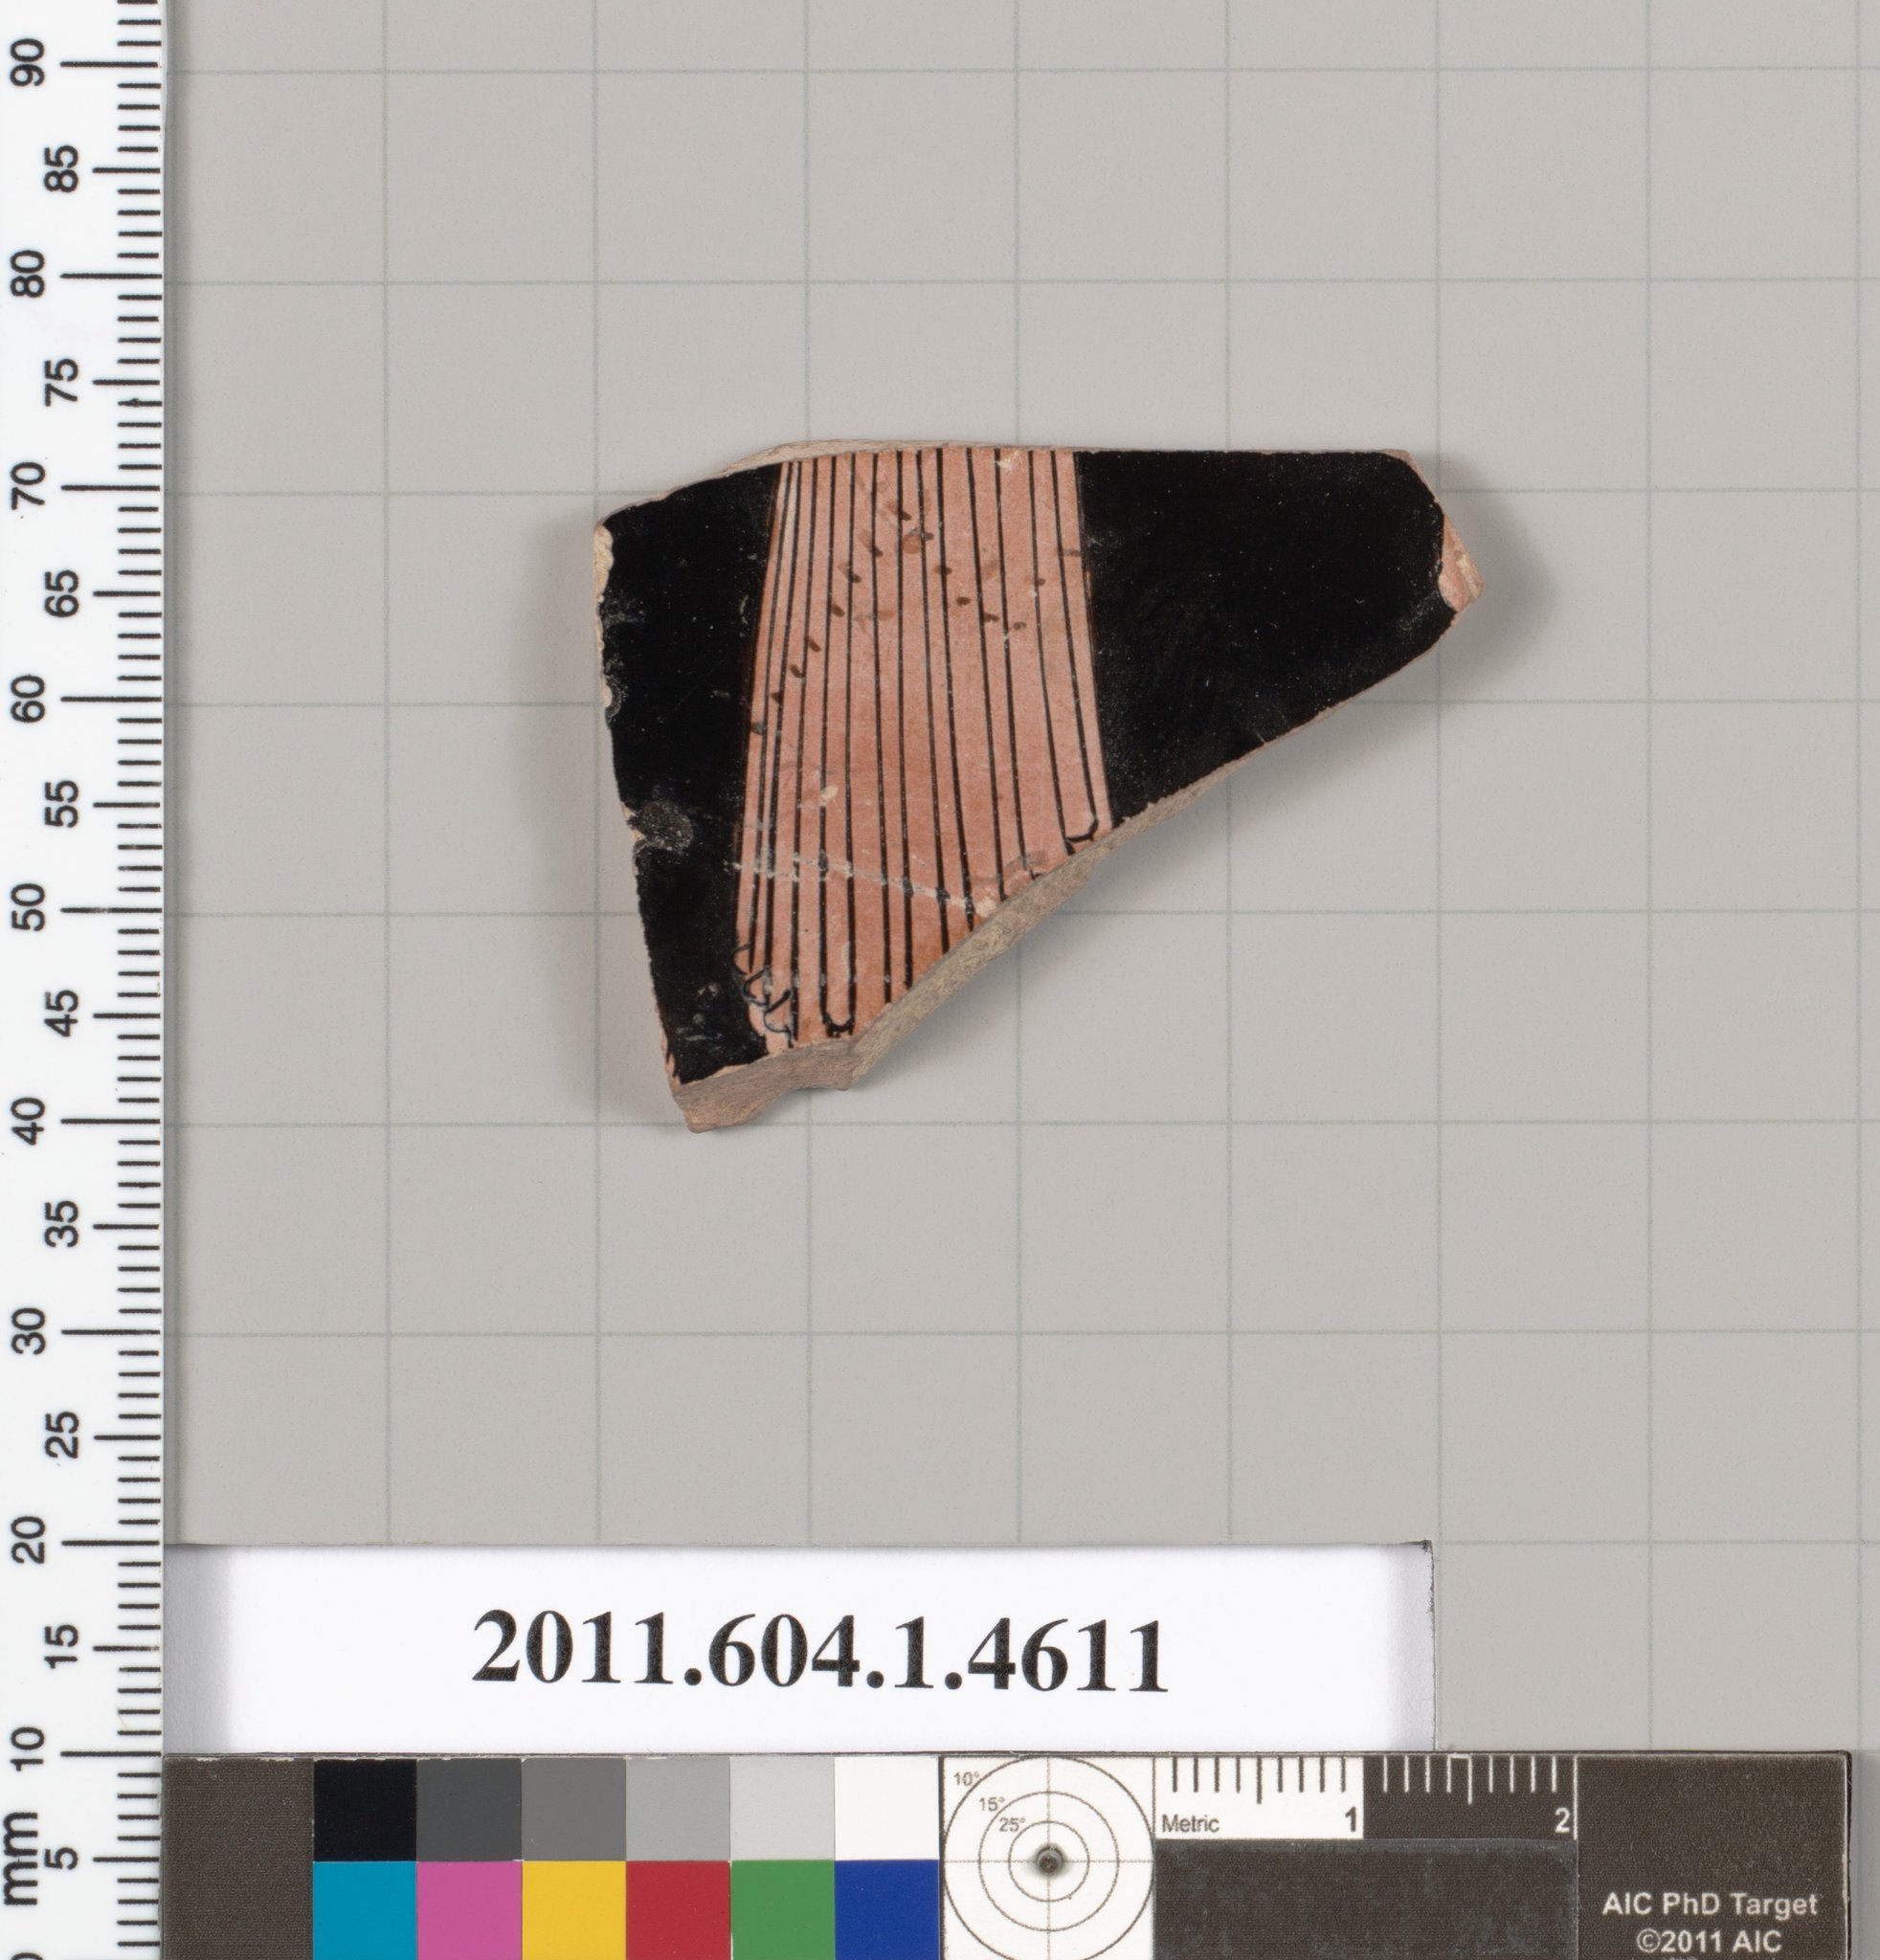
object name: kylix fragment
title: Terracotta fragment of a kylix (drinking cup)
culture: greek, attic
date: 500-490 BCE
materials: terracotta